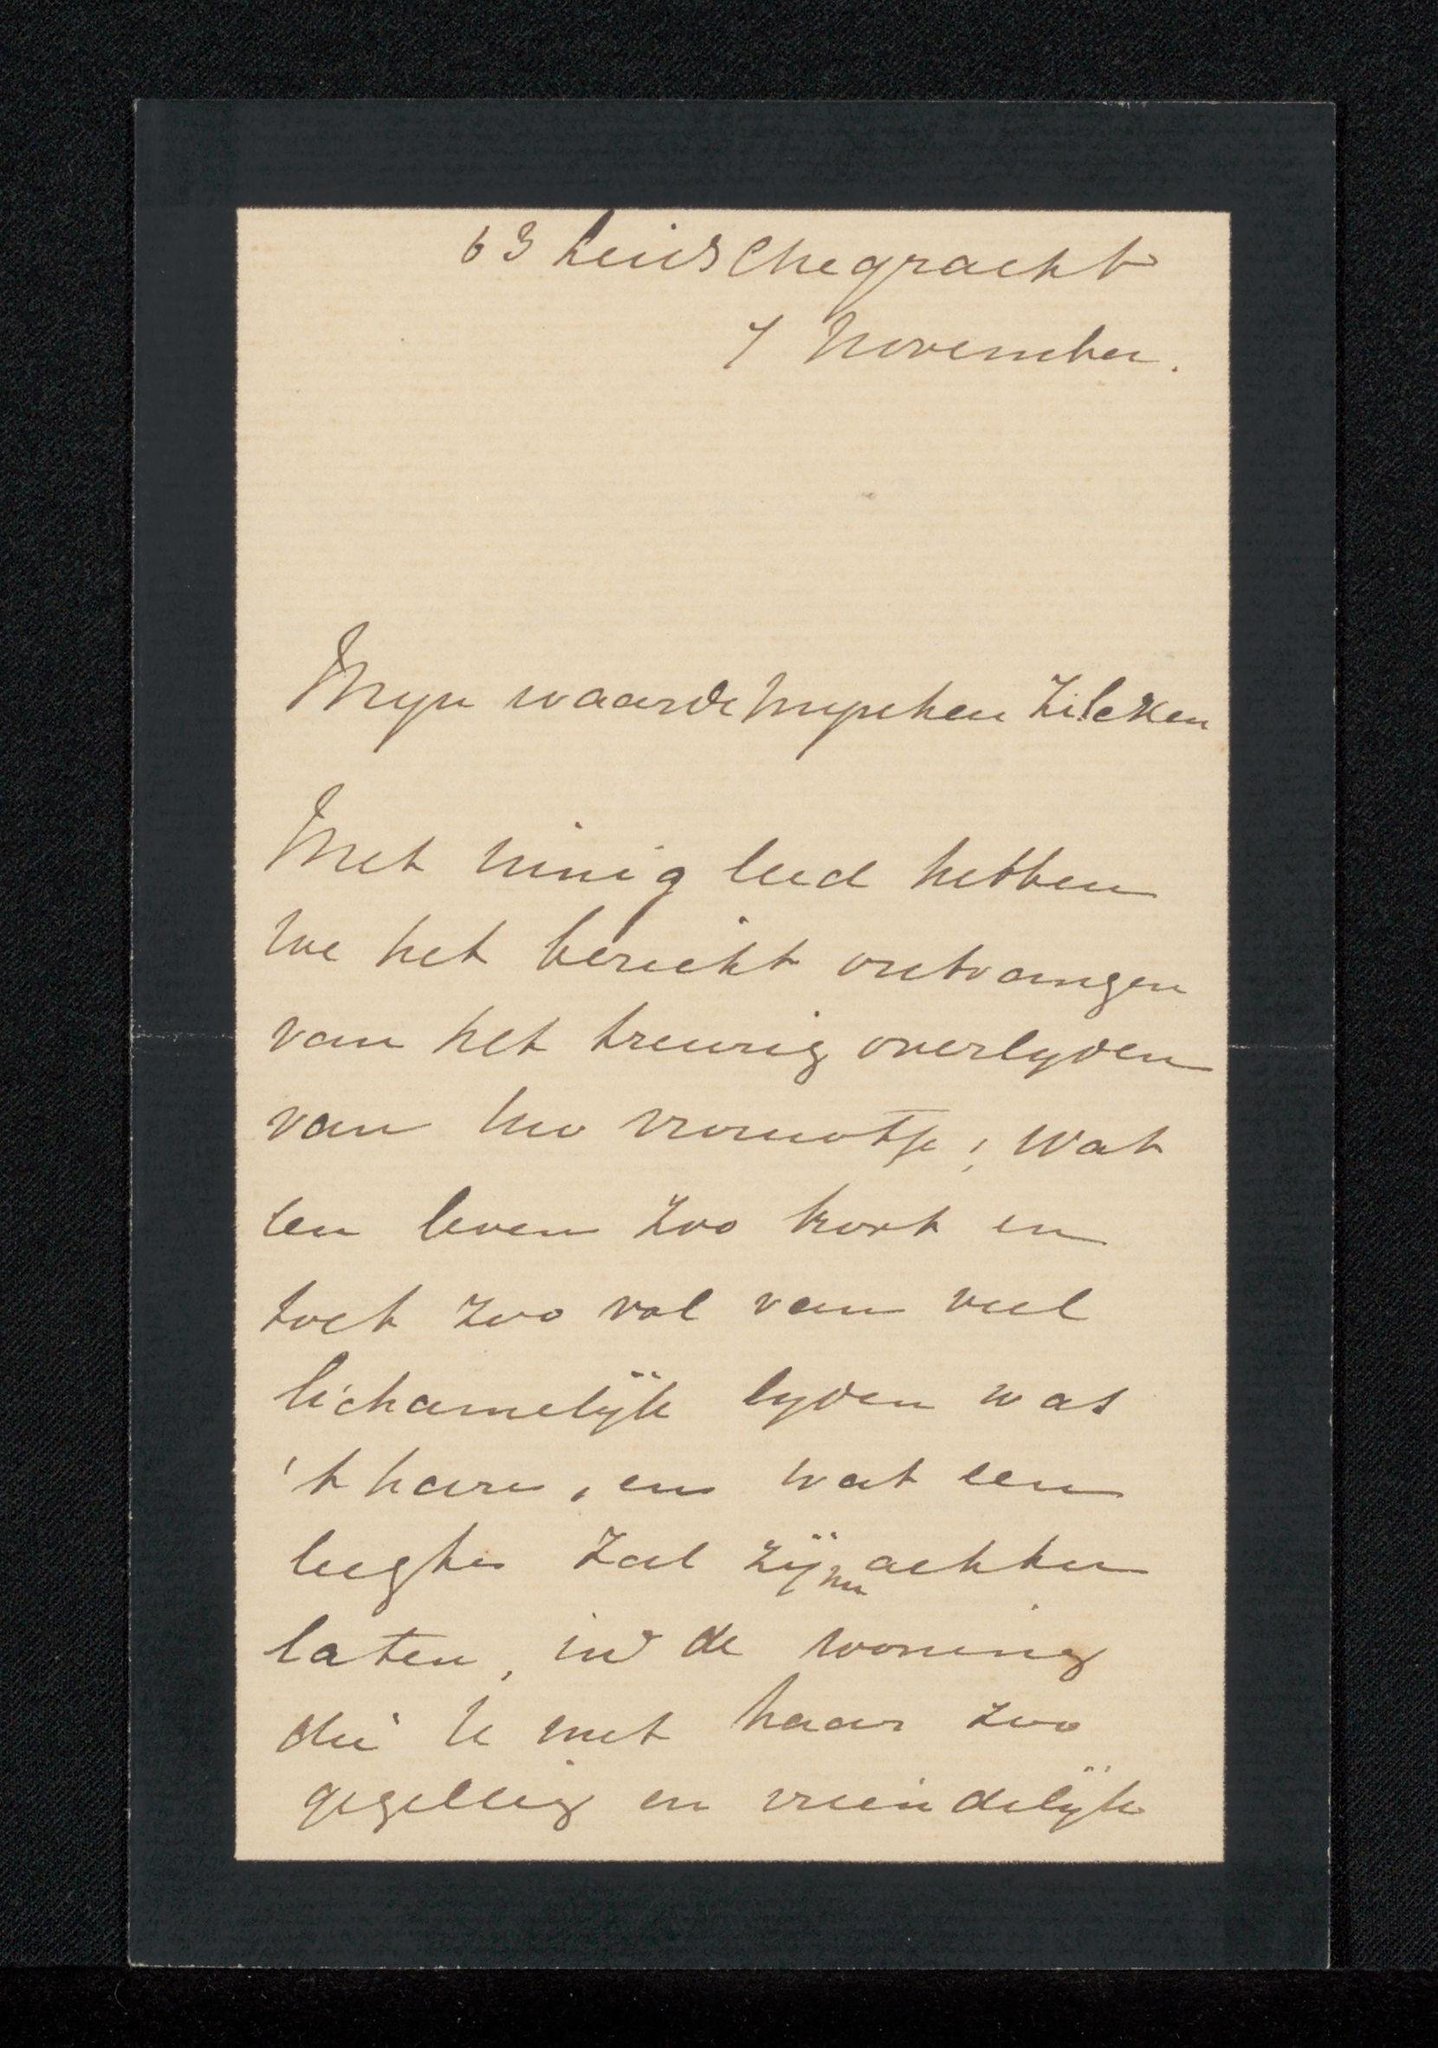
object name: letter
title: Brief aan Philip Zilcken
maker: e. voûte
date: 1895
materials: ink, paper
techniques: pen, writing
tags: renée hélène laure zilcken, helène lambertine hauzeur, the hague, painter, draughtsman, philip zilcken, passions, emotions, affections, diseases